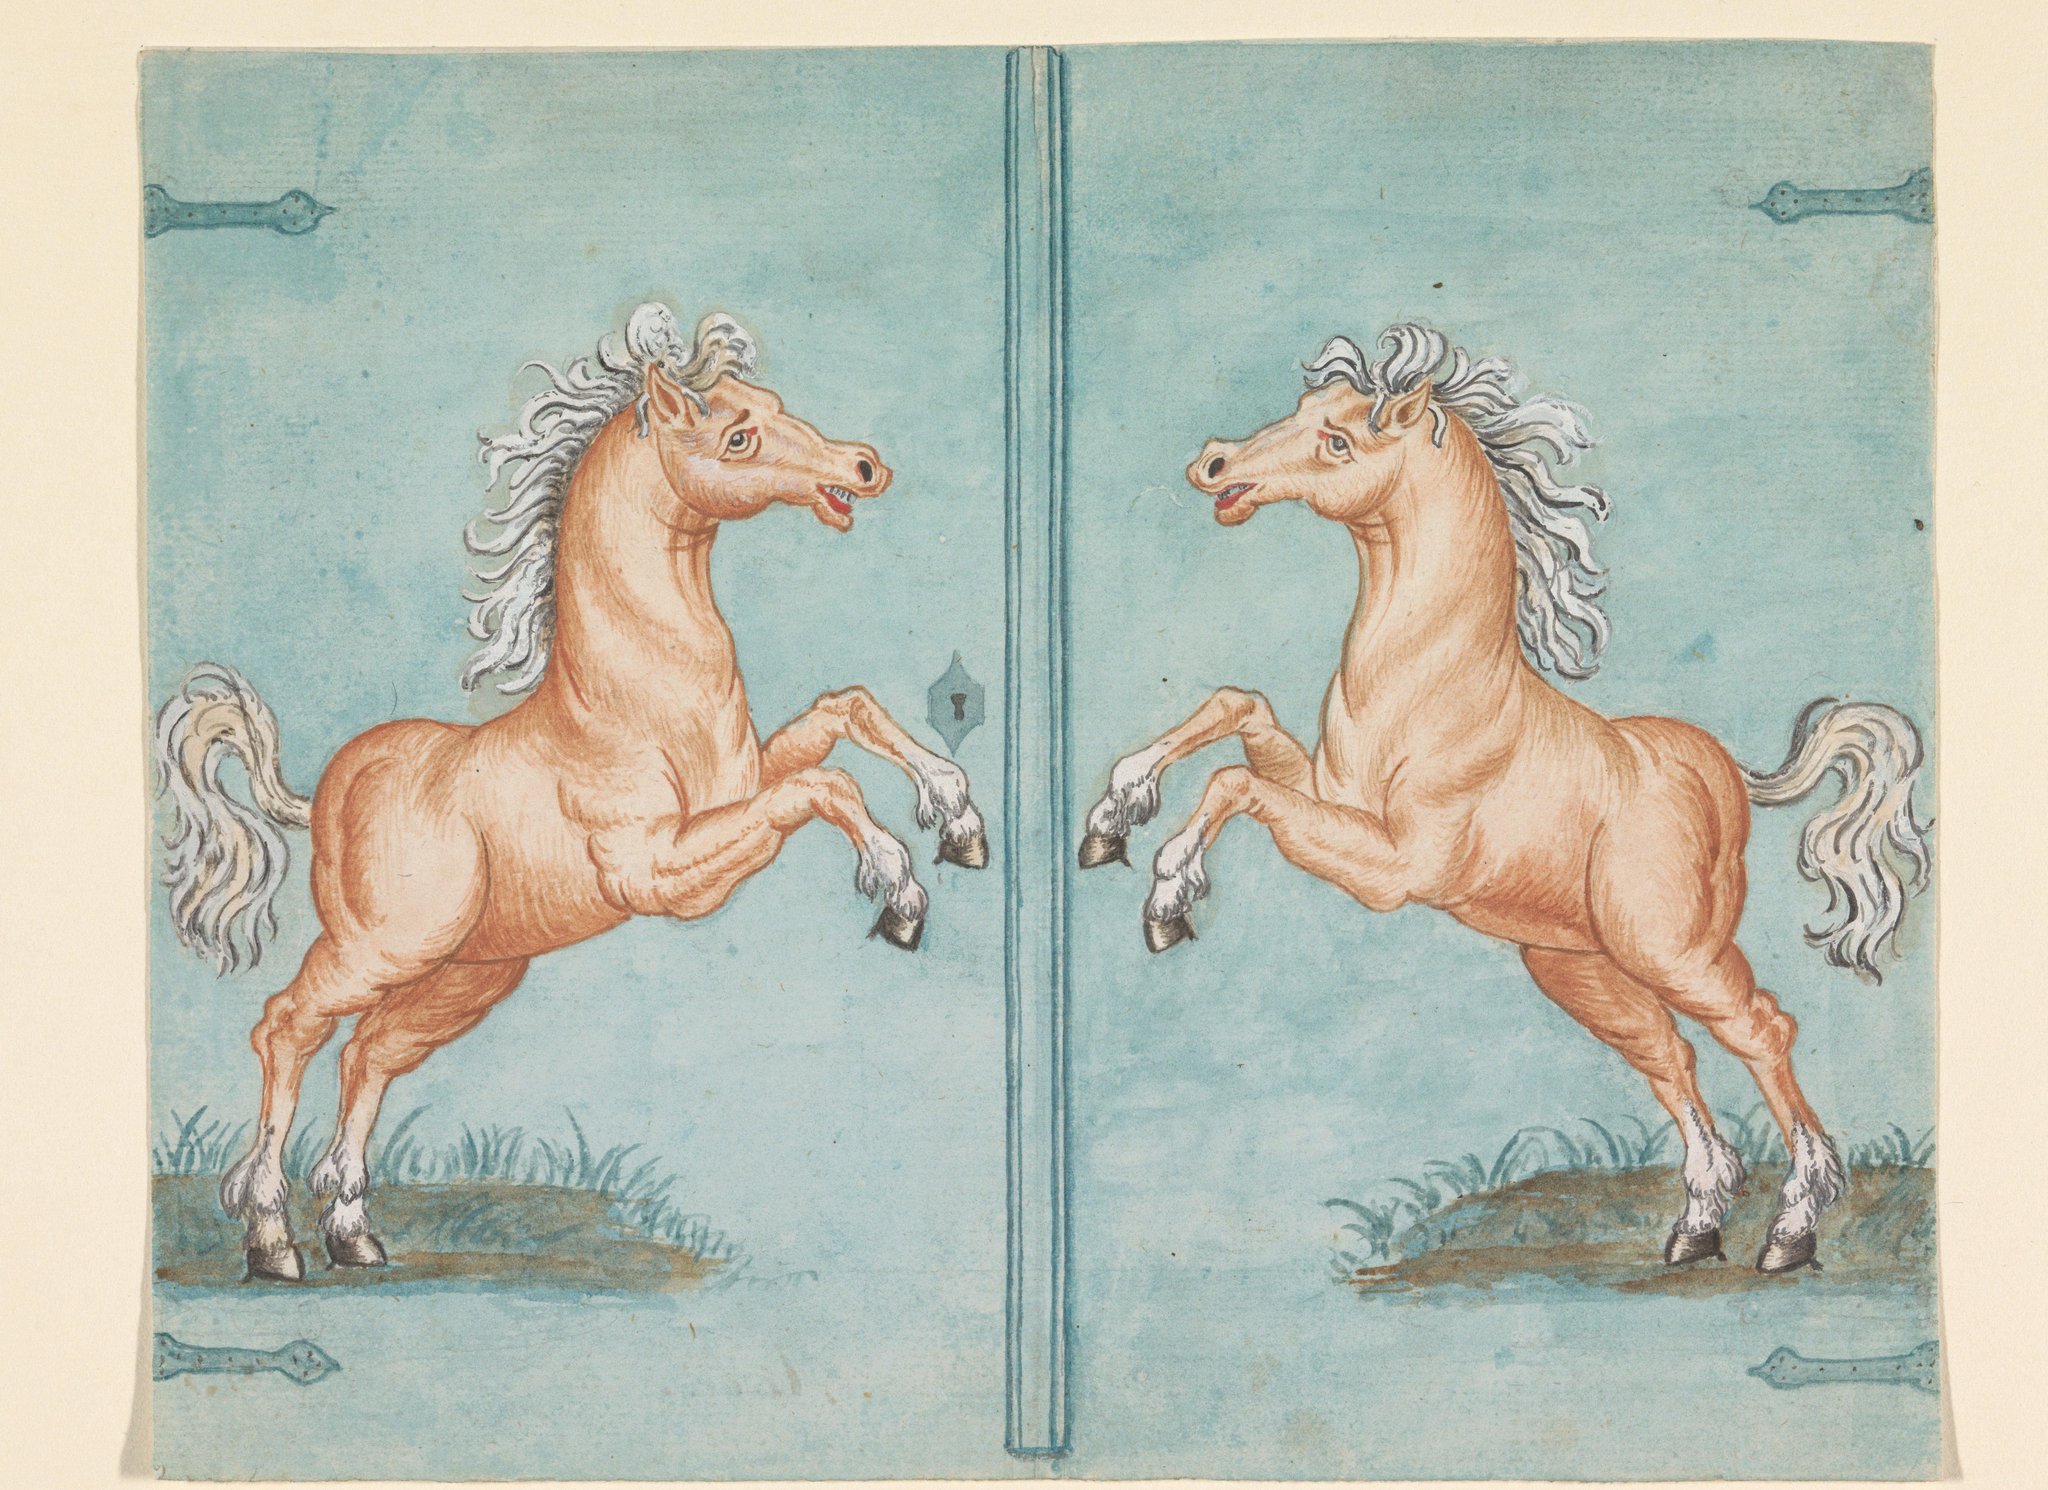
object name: design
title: Kastdeuren met paarden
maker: matthijs de jonker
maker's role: draughtsman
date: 1793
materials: paint, paper, watercolor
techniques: brush, pen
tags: furniture for storage, rearing (horse in motion)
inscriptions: collector's mark: Lugt 2228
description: Kastdeuren met twee steigerende paarden.